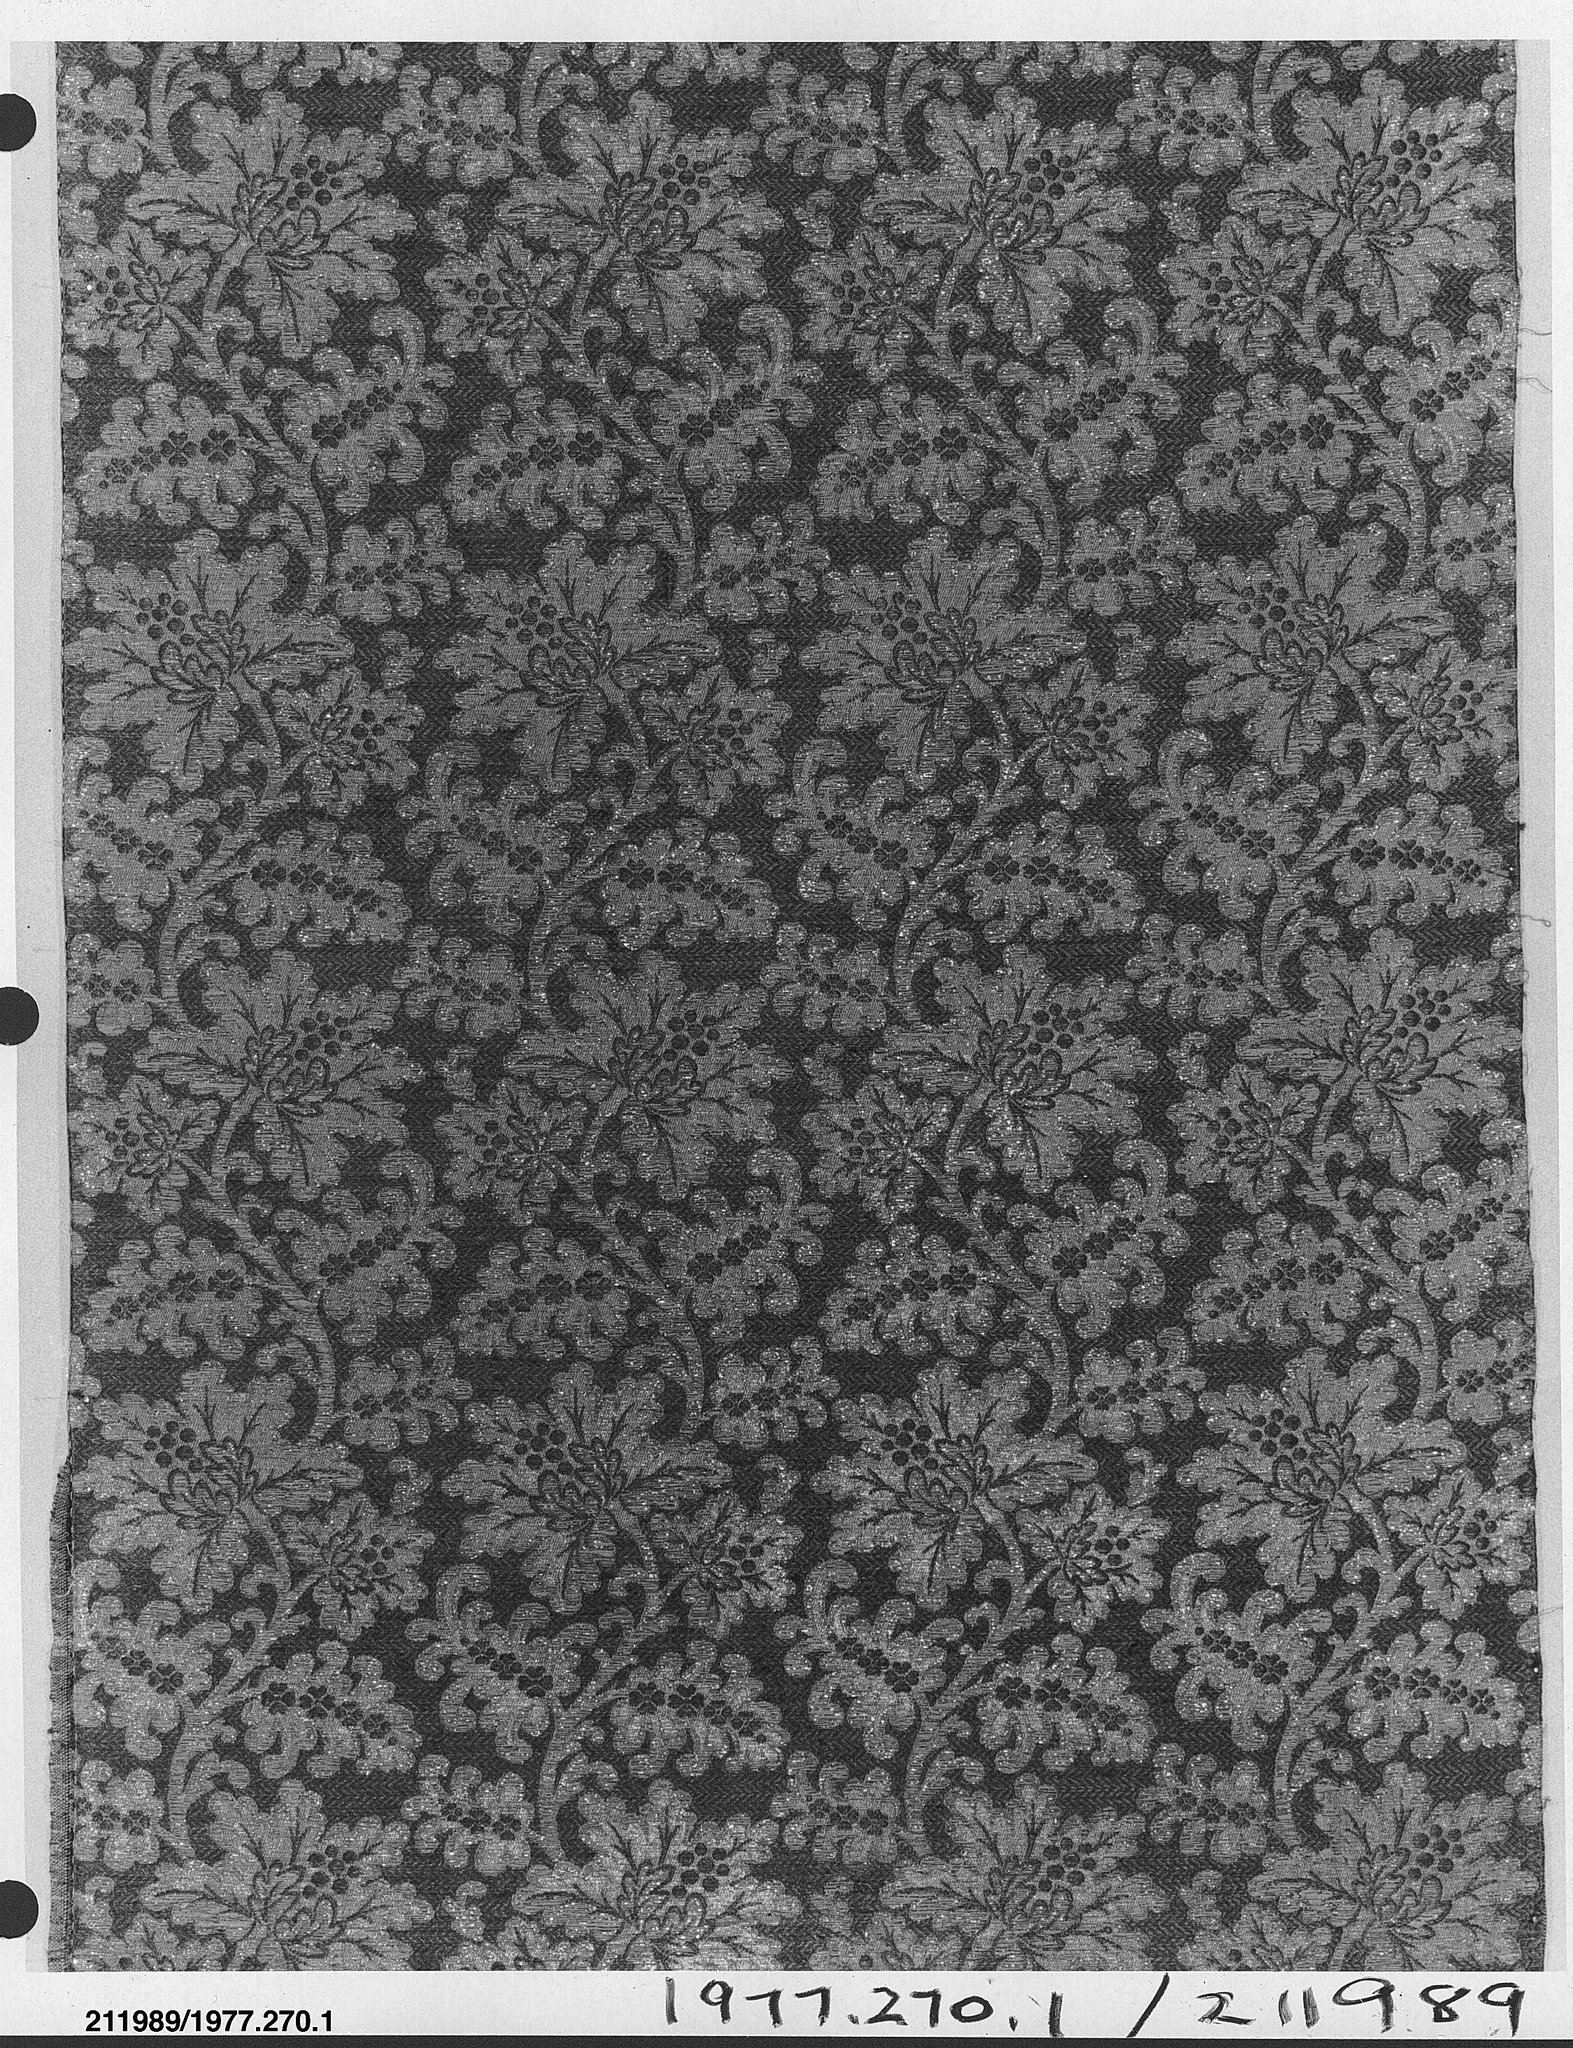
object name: panel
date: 1801-1900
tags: flowers